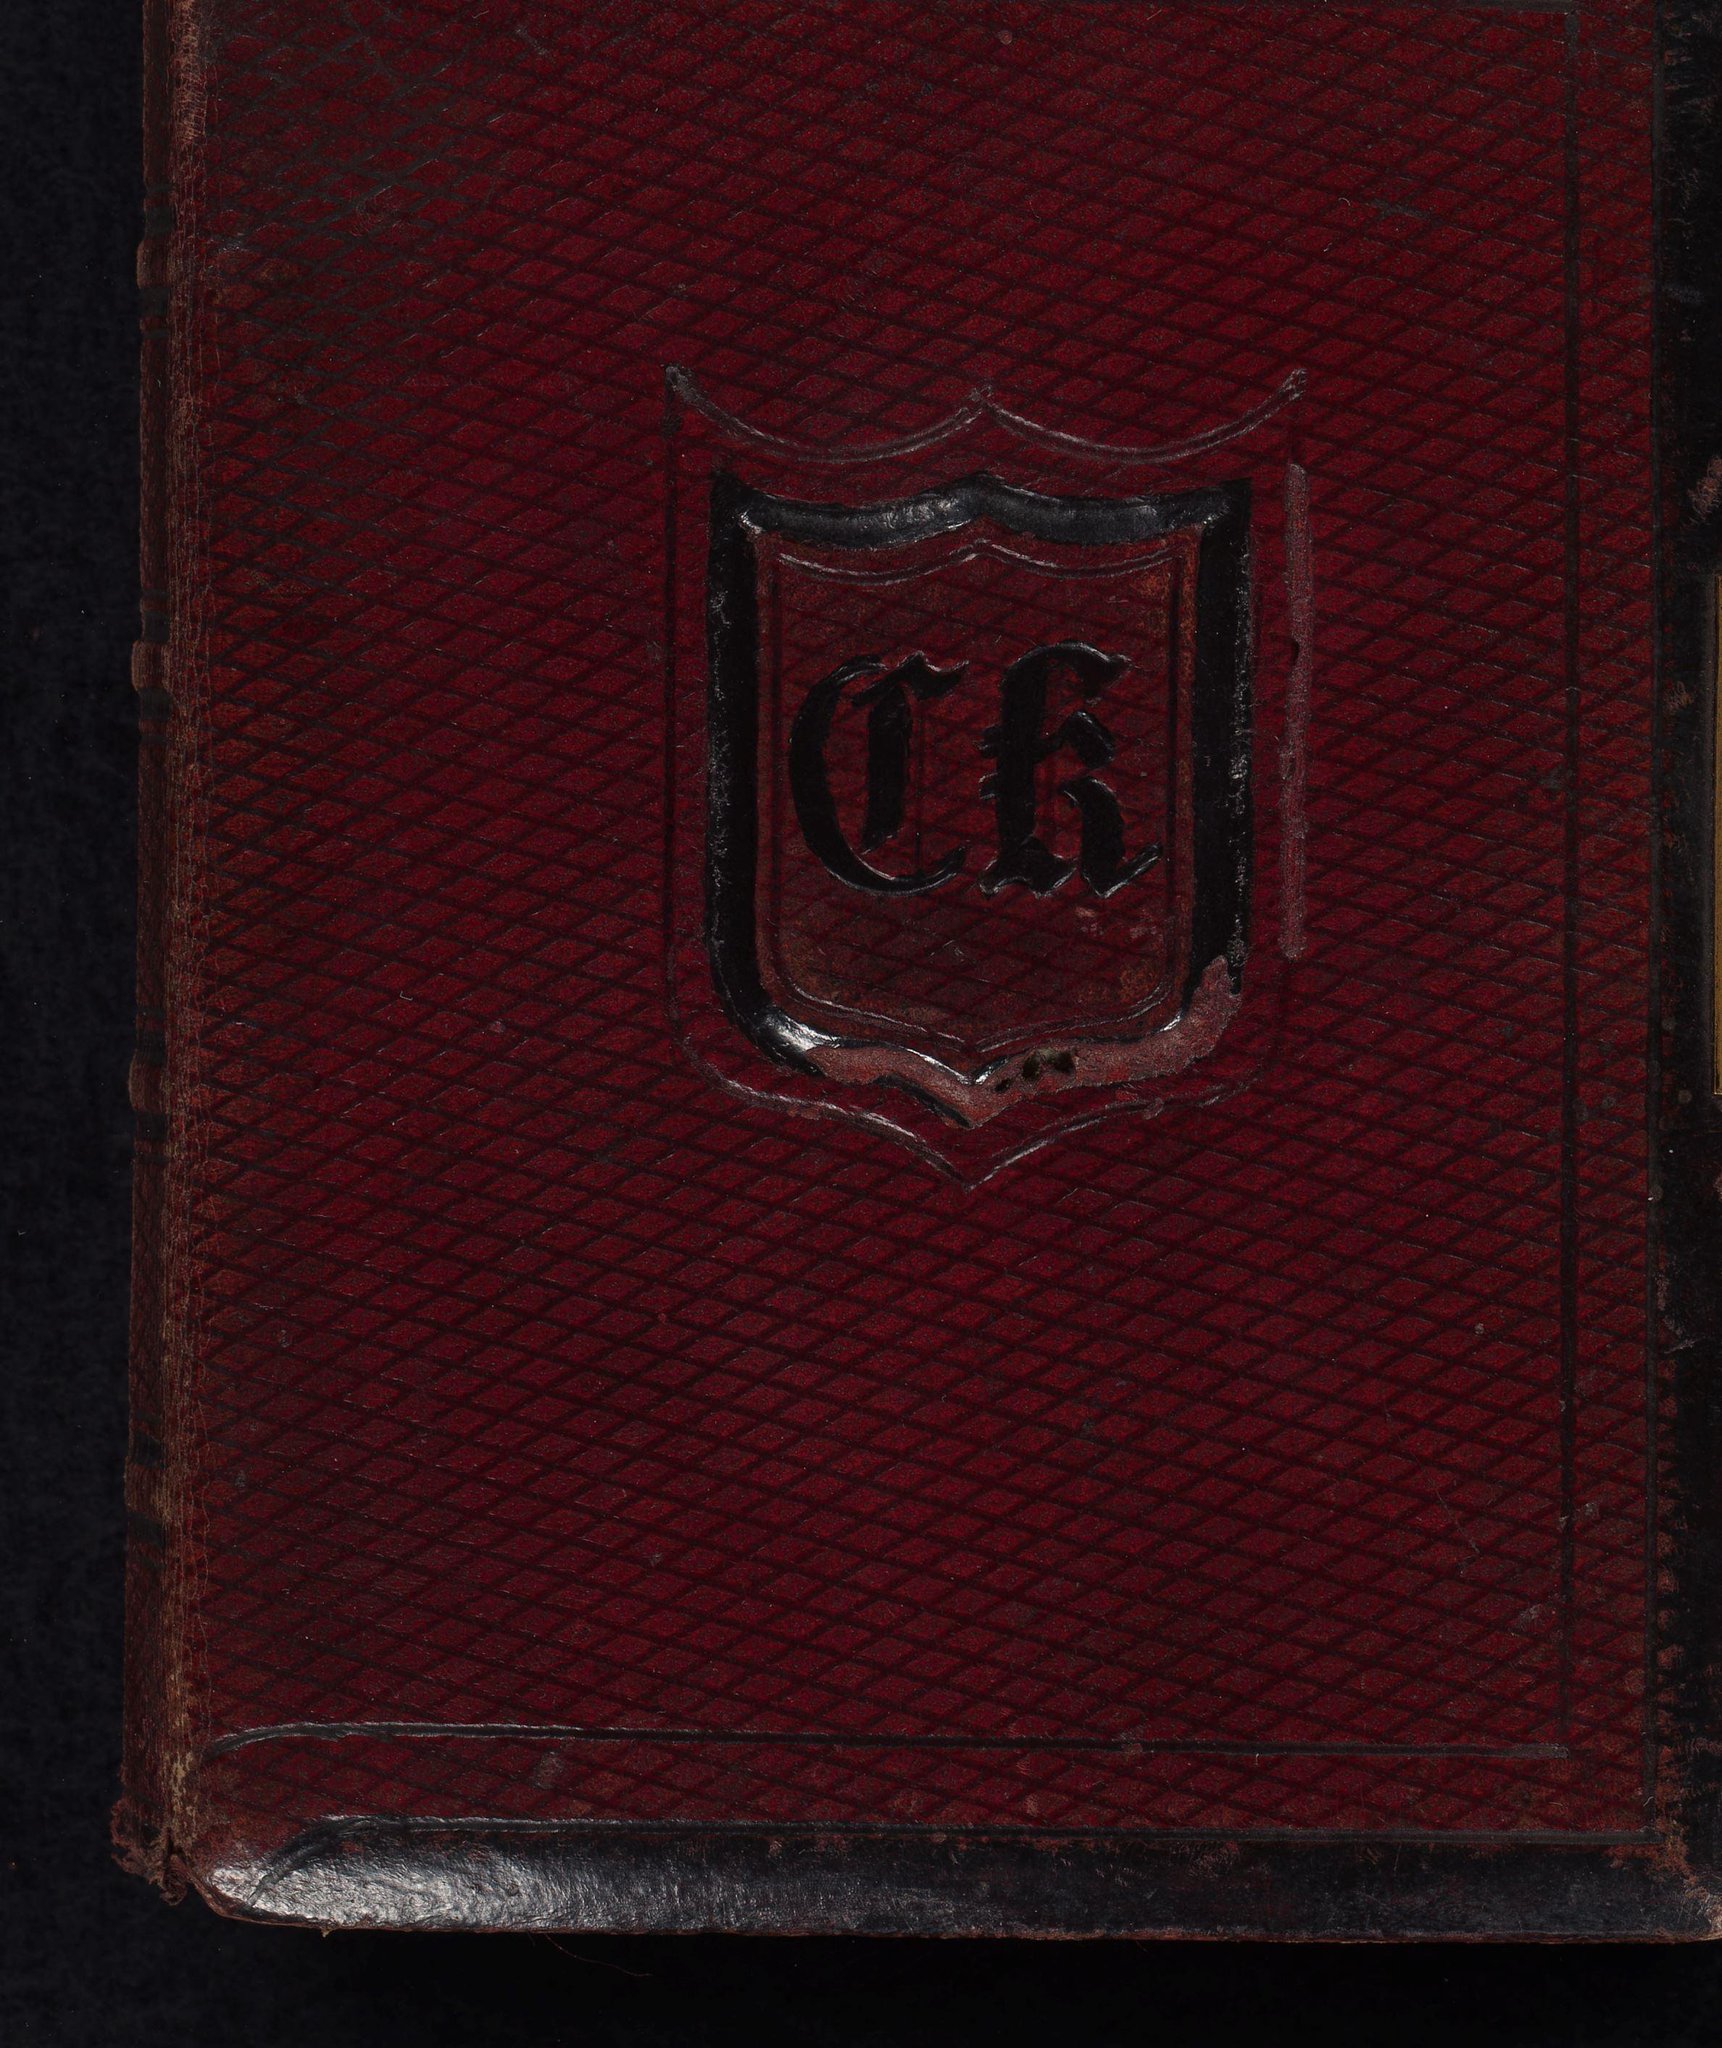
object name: slip in album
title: Fotoalbum met 49 foto's, Frans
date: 1860-1900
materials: cardboard, leather, metal, paper, photographic support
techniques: albumen print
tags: adolescent, young woman, maiden, historical persons - bb - woman, boy (child between toddler and youth), historical persons, girl (child between toddler and youth), beard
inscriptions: collector's mark: ‘Dienst Verspreide Rijkscollekties/ Inv.nr: A760’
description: Fotoalbum met 25 bladen met in totaal 49 foto's. Het album bevat voornamelijk portretten die veelal in Frankrijk zijn vervaardigd, onder andere door Mayer & Pierson, Constant Peigné en Pierre Petit, enkele zijn anoniem. Twee foto's zitten los voorin het album.